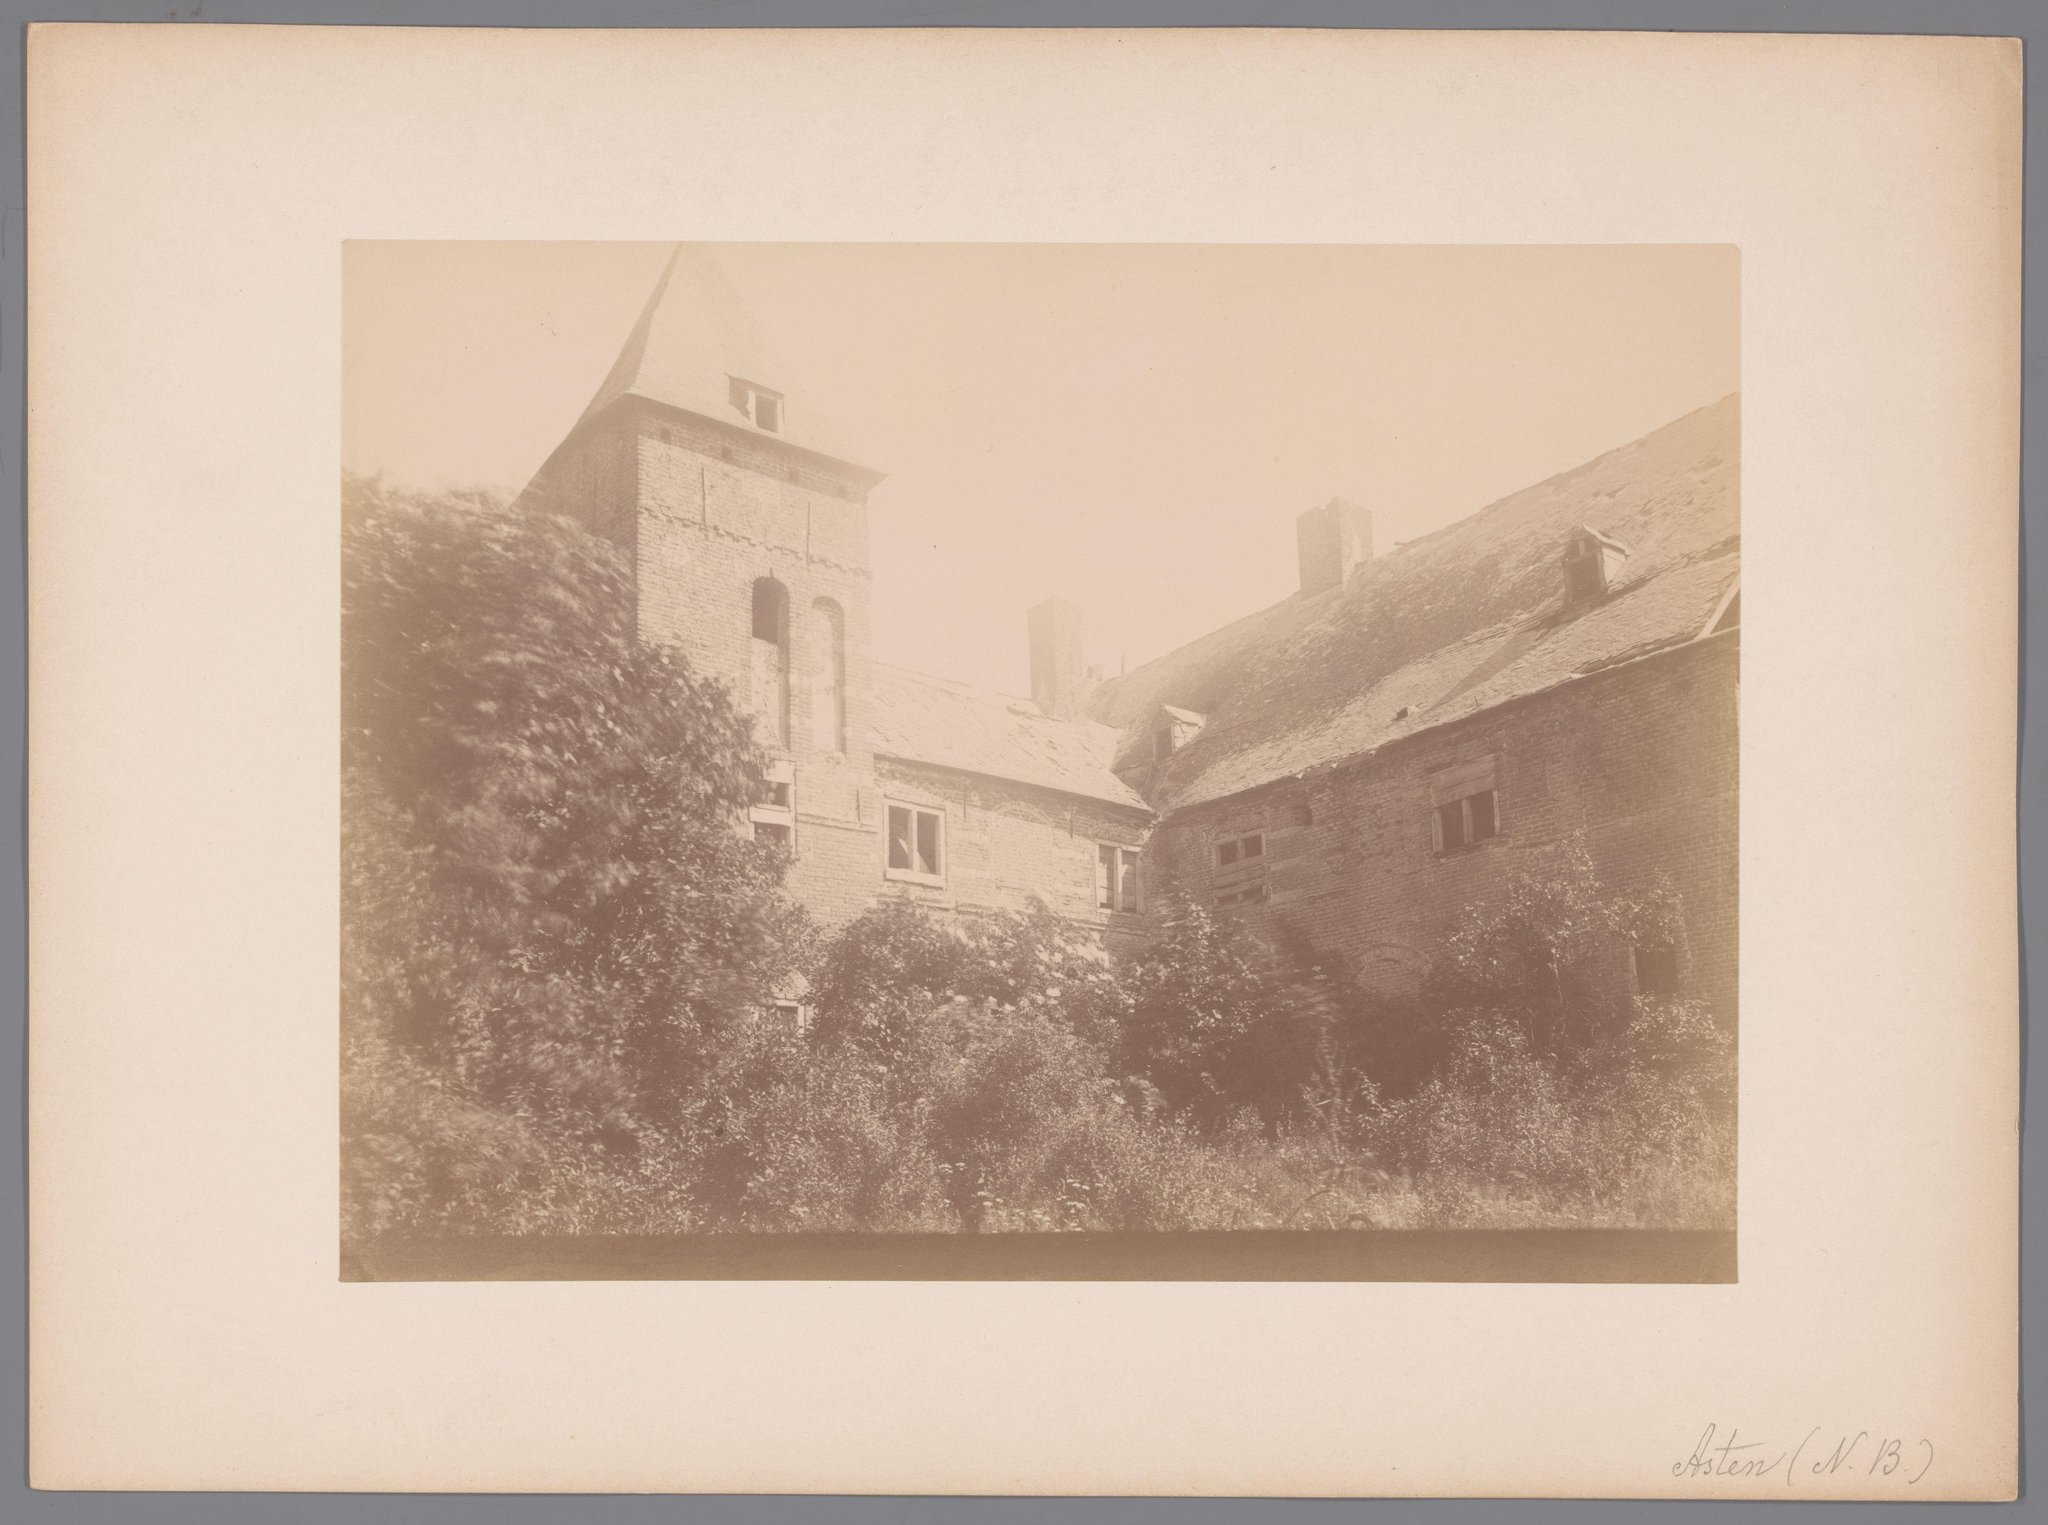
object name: photograph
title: Schoorsteen in de kasteelruïne van Asten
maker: anoniem (monumentenzorg)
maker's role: fotograaf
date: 1890-1920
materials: cardboard, photographic support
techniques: albumen print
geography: asten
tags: castle, chimney-piece, mantelpiece, ruin of a dwelling, house, castle, etc.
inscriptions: annotation: ‘Asten (N.B.)’, annotation: ‘Kasteel (ruine) te Asten/ schoorsteen’